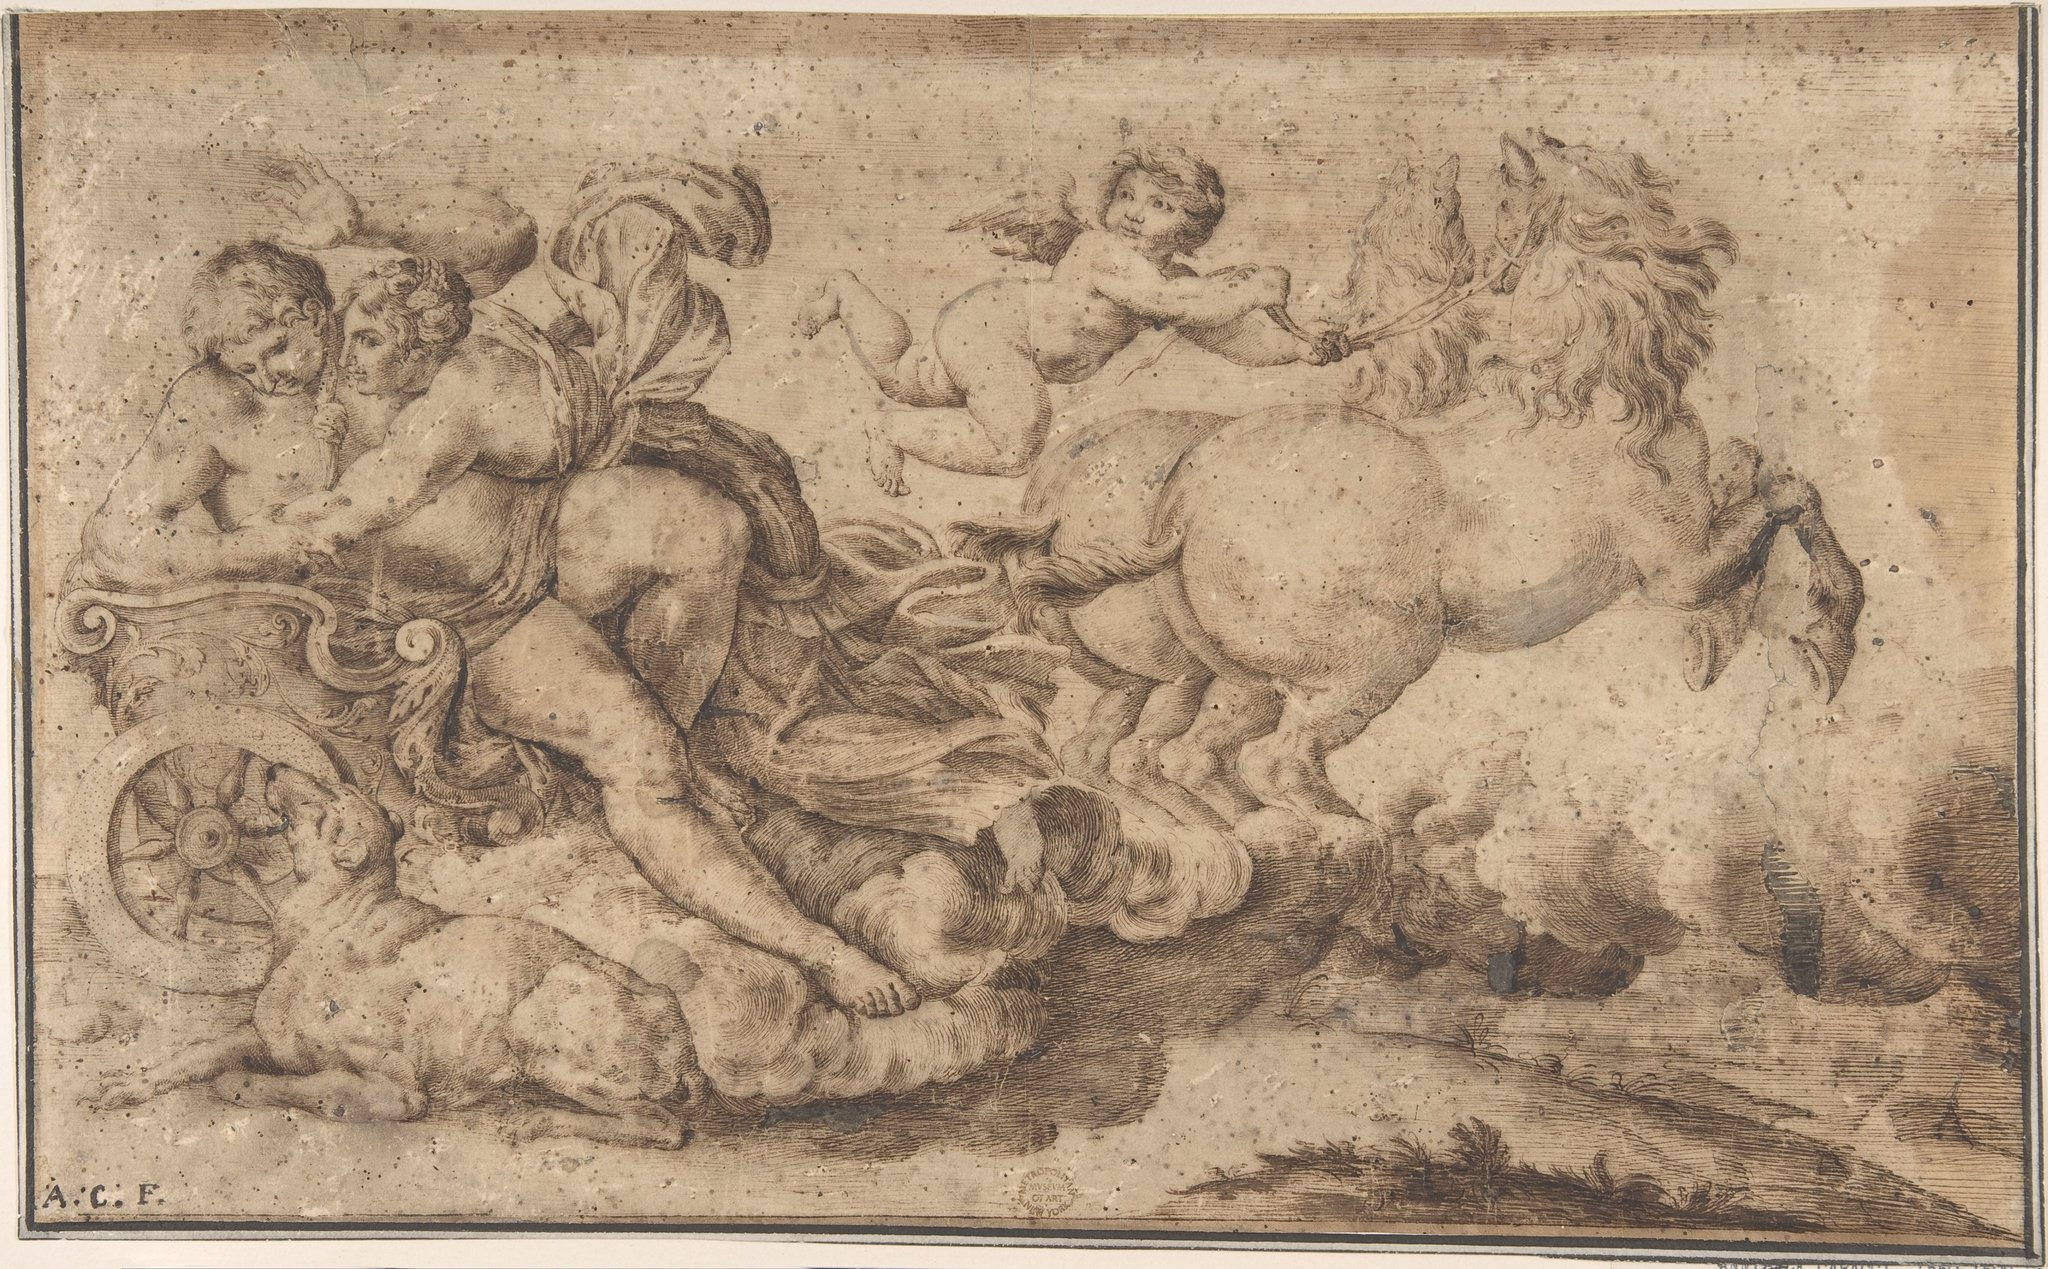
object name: drawing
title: Aurora and Cephalus: Engraver's study after decoration in the Galleria Farnese, Rome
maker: anonymous, italian, roman-bolognese, 17th century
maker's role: artist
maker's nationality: italian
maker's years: 1600-1700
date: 1601-1700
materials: ink, paper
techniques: brush, pen, wash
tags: animals,men,cupid,carriages